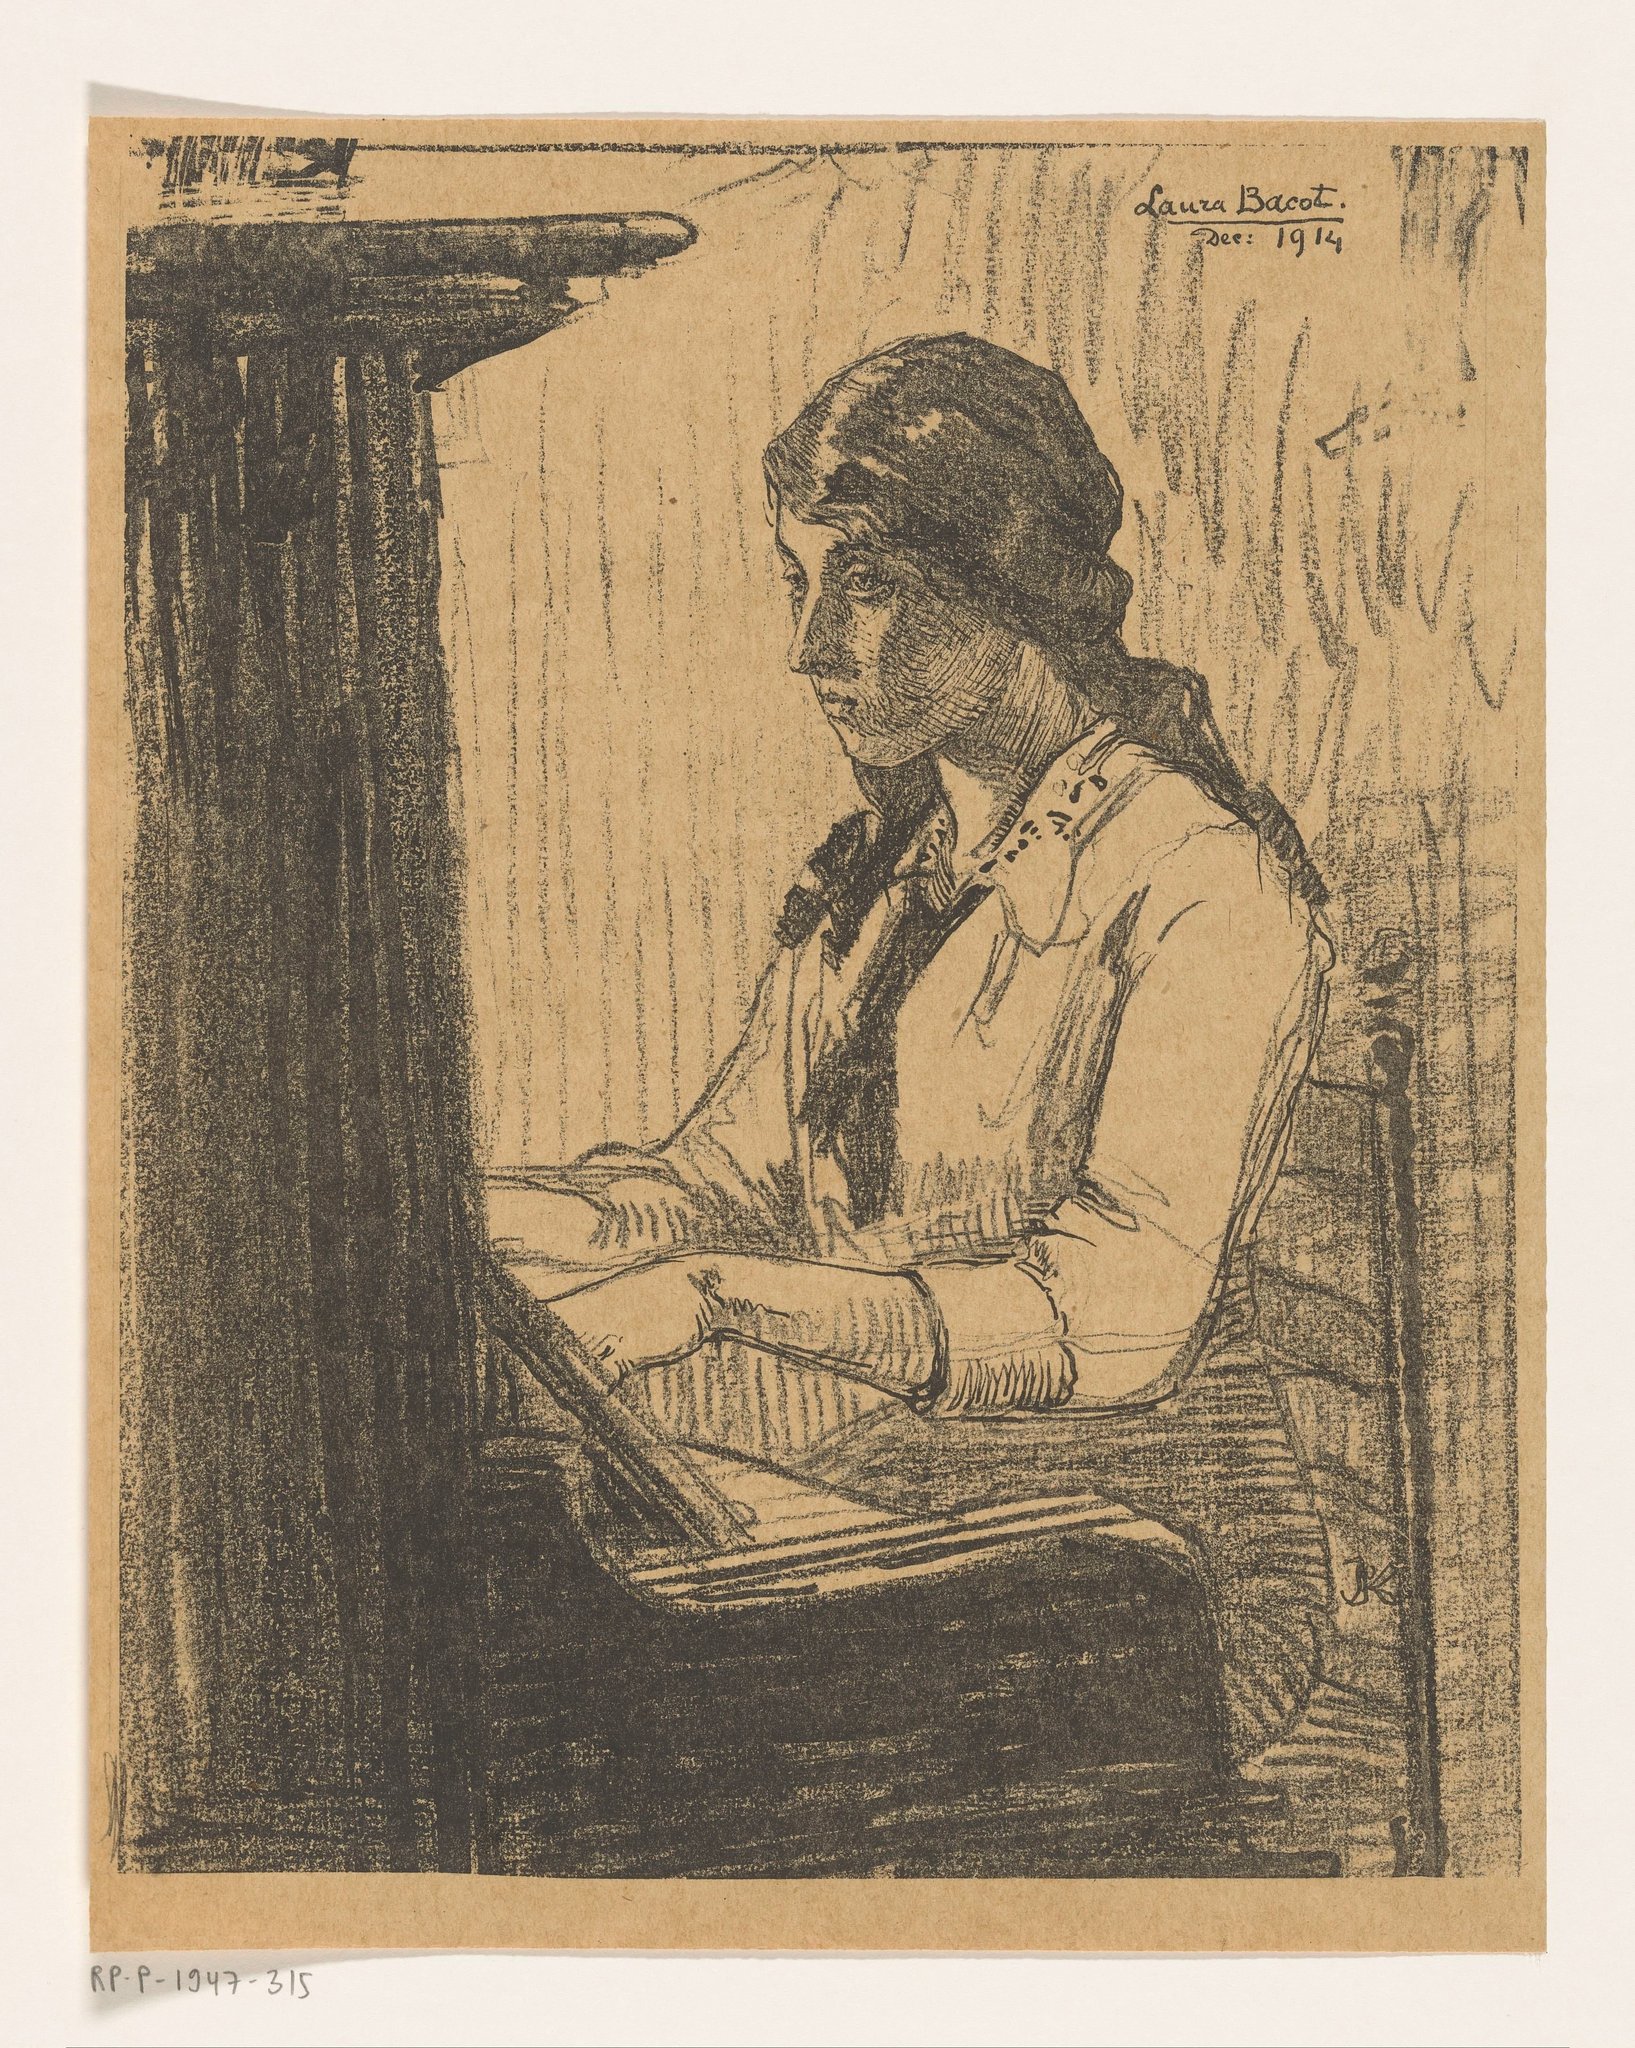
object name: print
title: Laura Bacot die een piano bespeelt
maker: jo koster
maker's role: print maker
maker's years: 1869-1944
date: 1912-1914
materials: paper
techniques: lithograph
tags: one person playing keyboard instrument, pianoforte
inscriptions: collector's mark: Lugt 2228